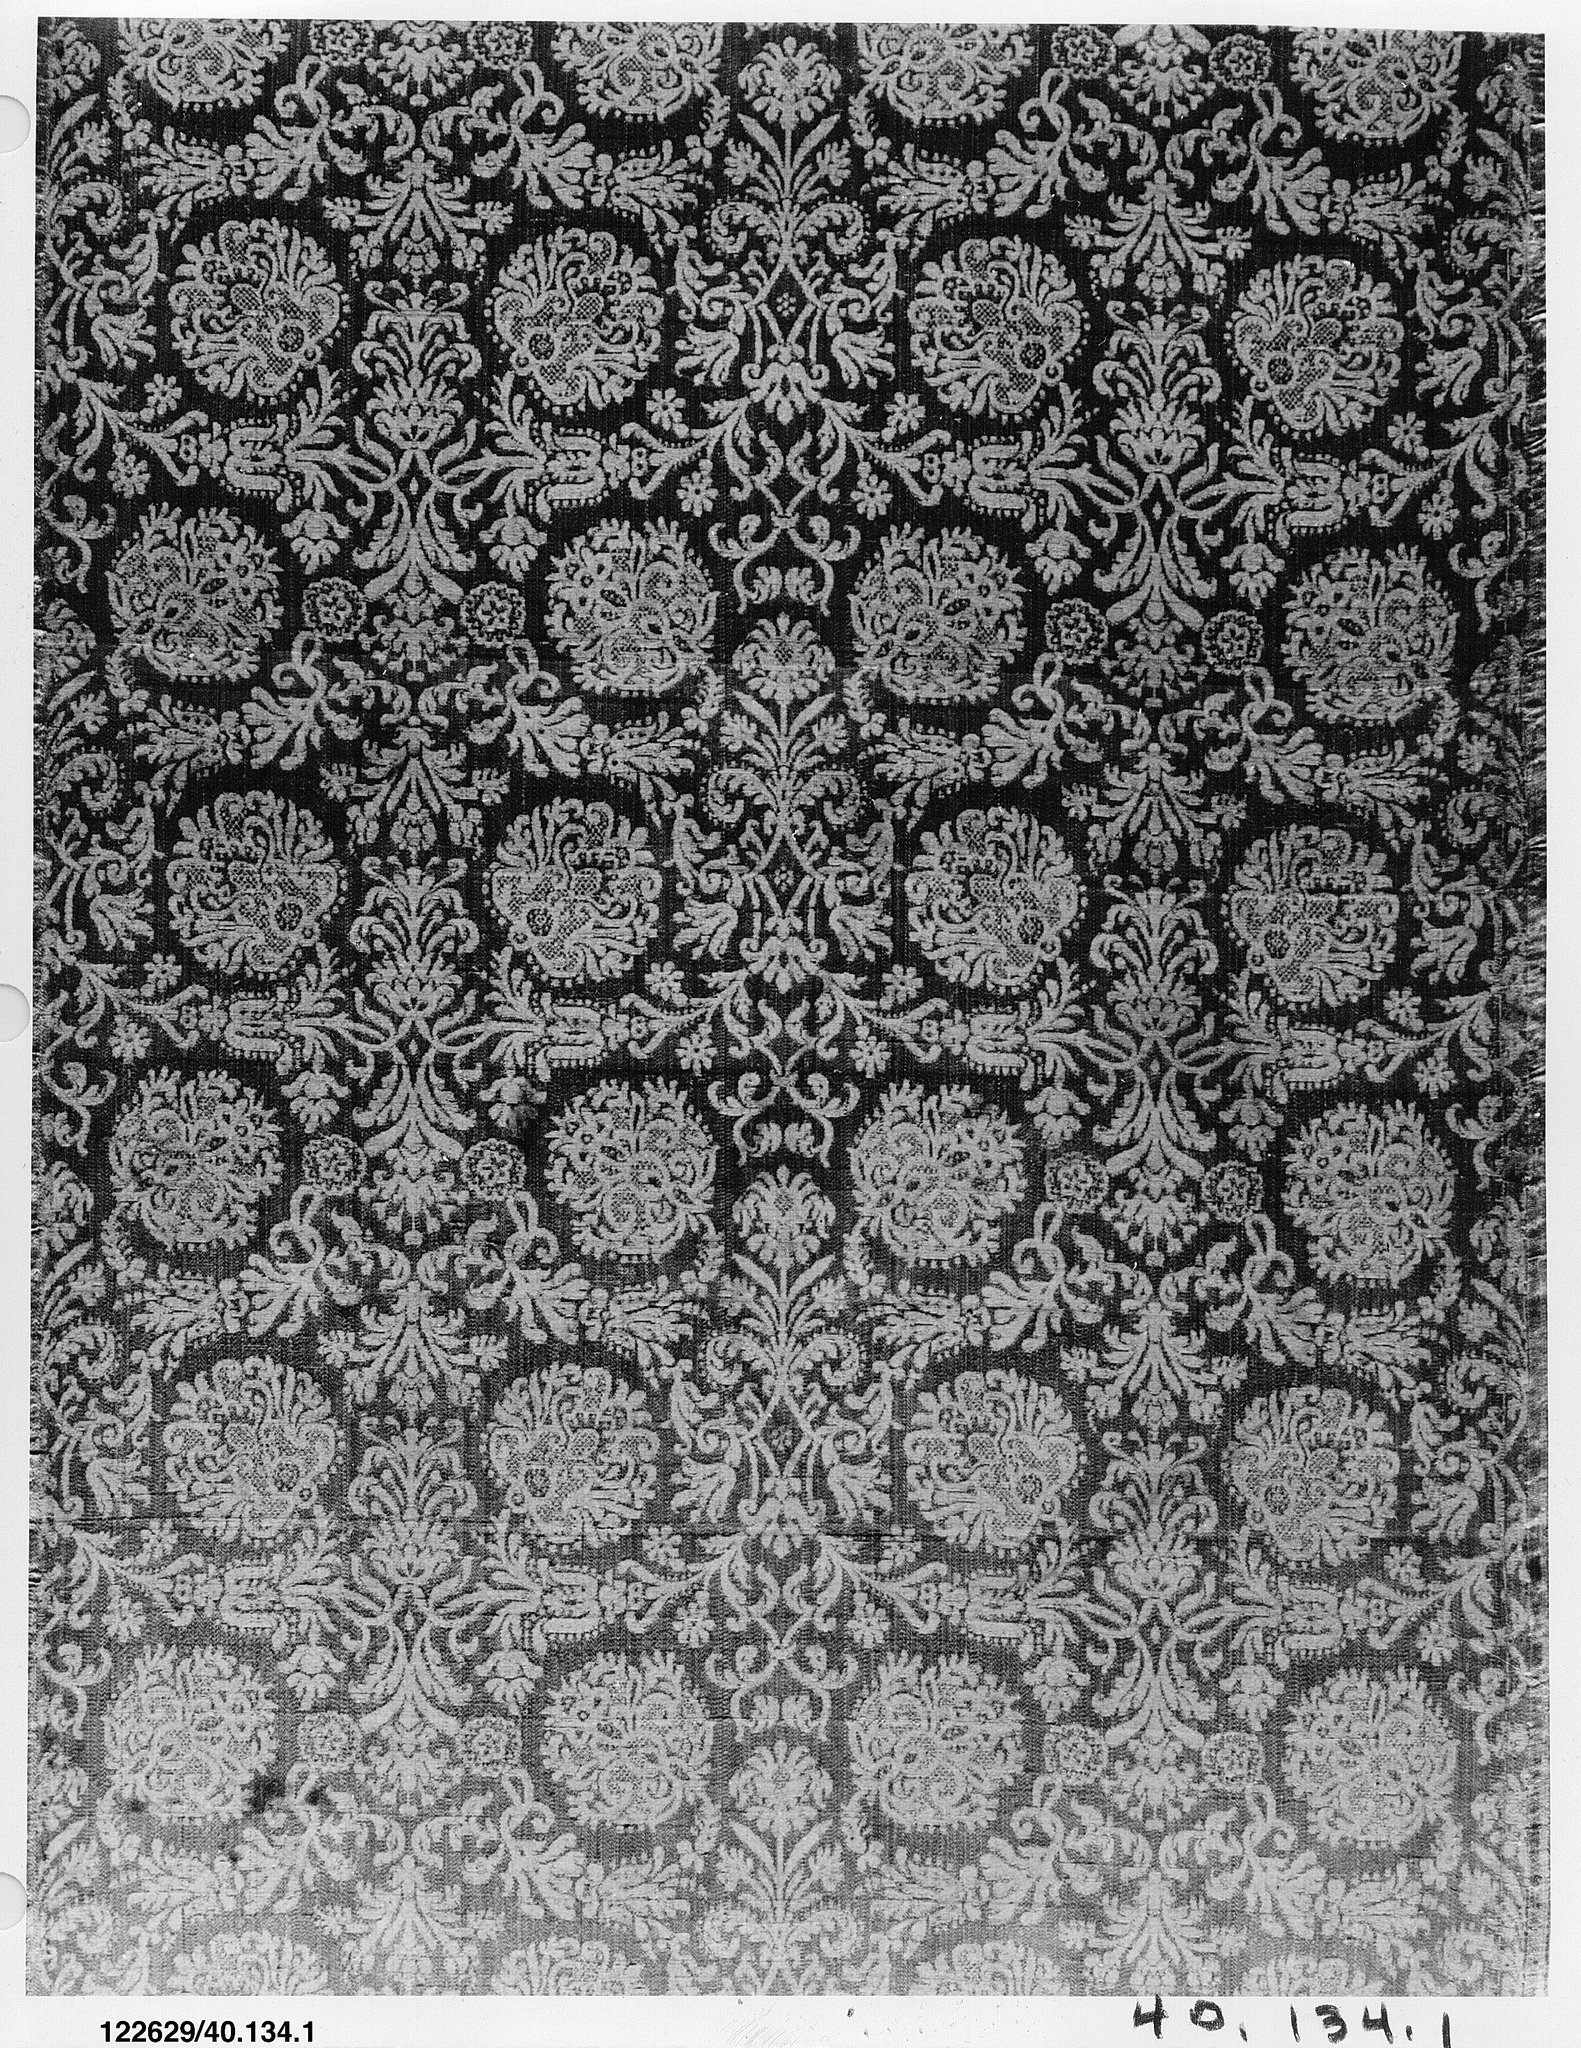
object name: piece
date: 1567-1600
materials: silk